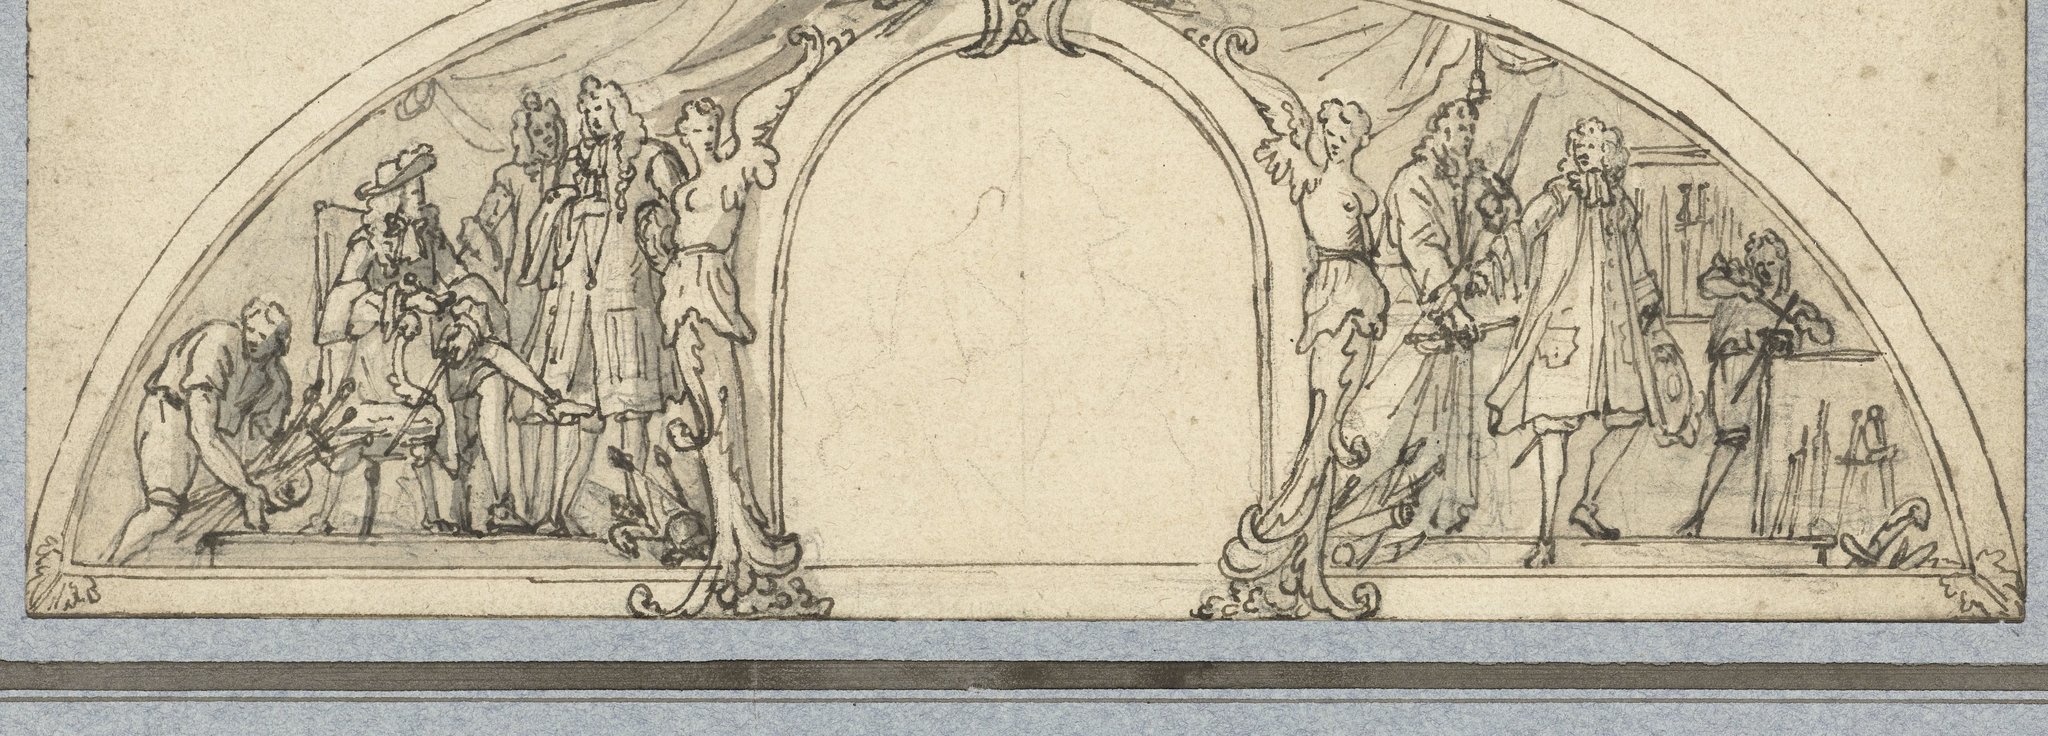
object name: drawing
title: Studie voor een vignet voor een boek over het schermen (?)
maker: bernard picart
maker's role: draughtsman, print maker, publisher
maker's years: 1673-1733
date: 1683-1733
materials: ink, paper, pencil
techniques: brush, pen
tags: fencing (sport)